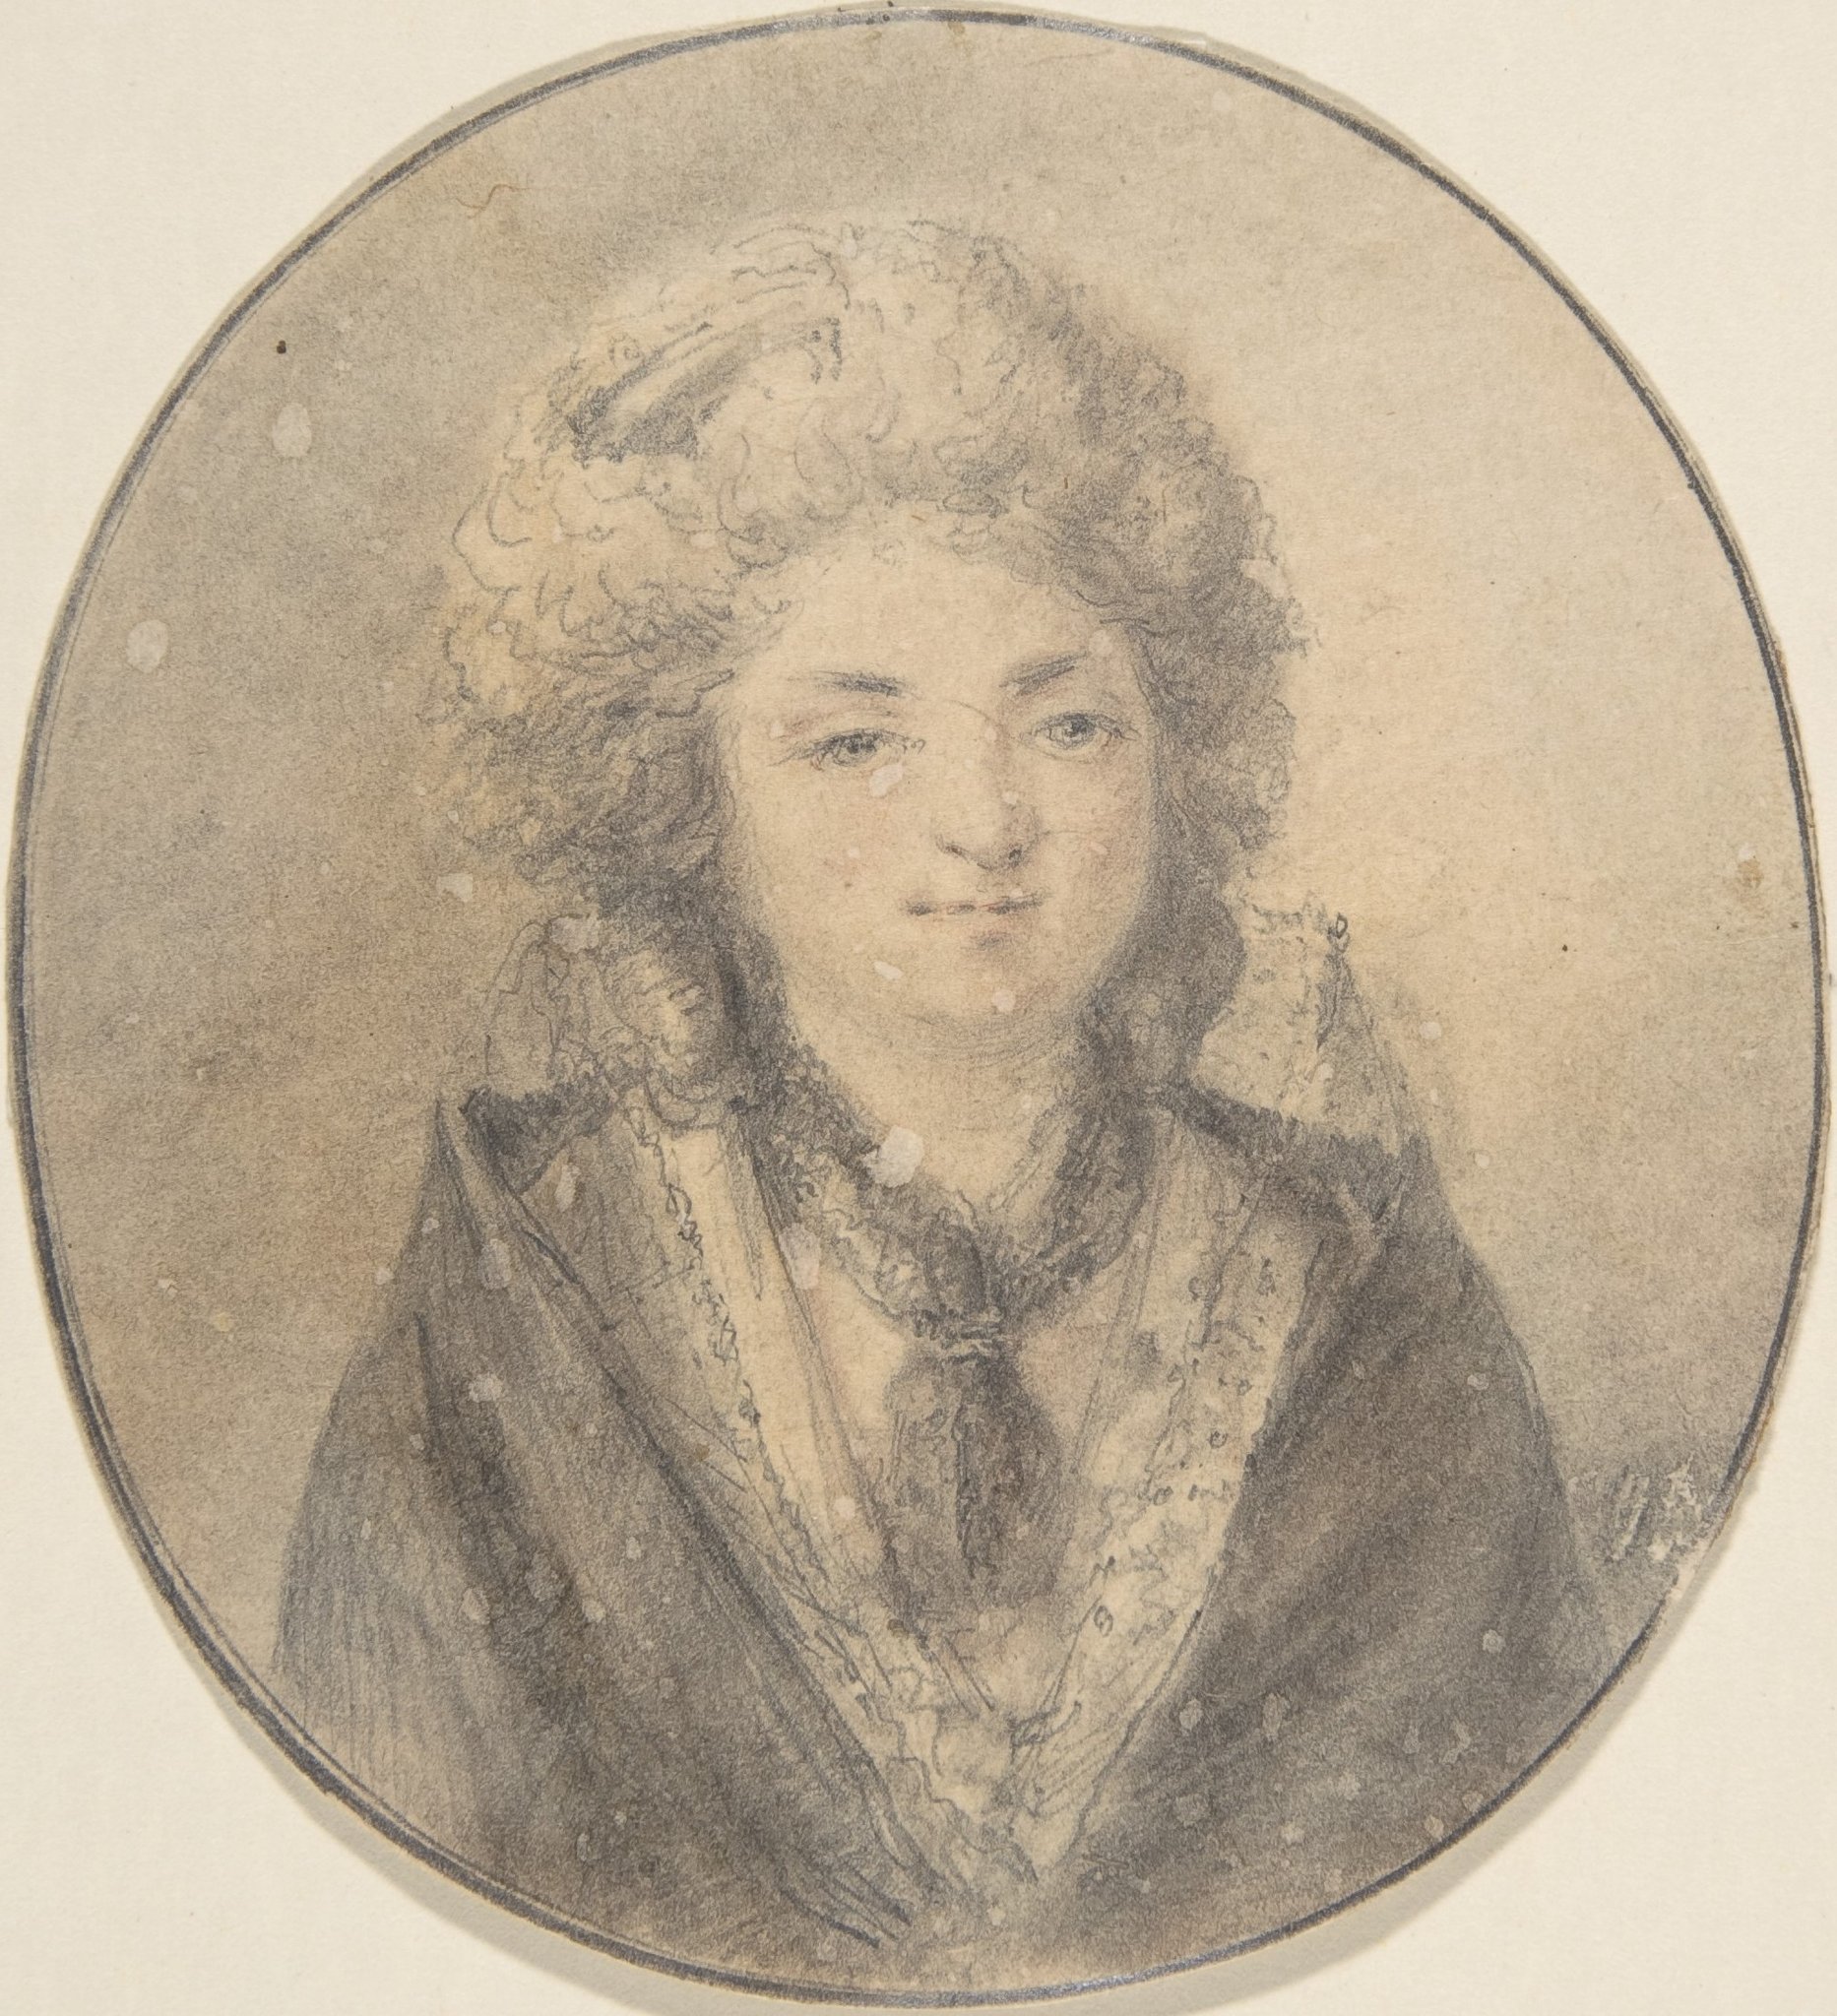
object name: drawing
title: Bust of a Woman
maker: anonymous, french, 18th century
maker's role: artist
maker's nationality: french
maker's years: 1700-1800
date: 1701-1800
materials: graphite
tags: portraits,women